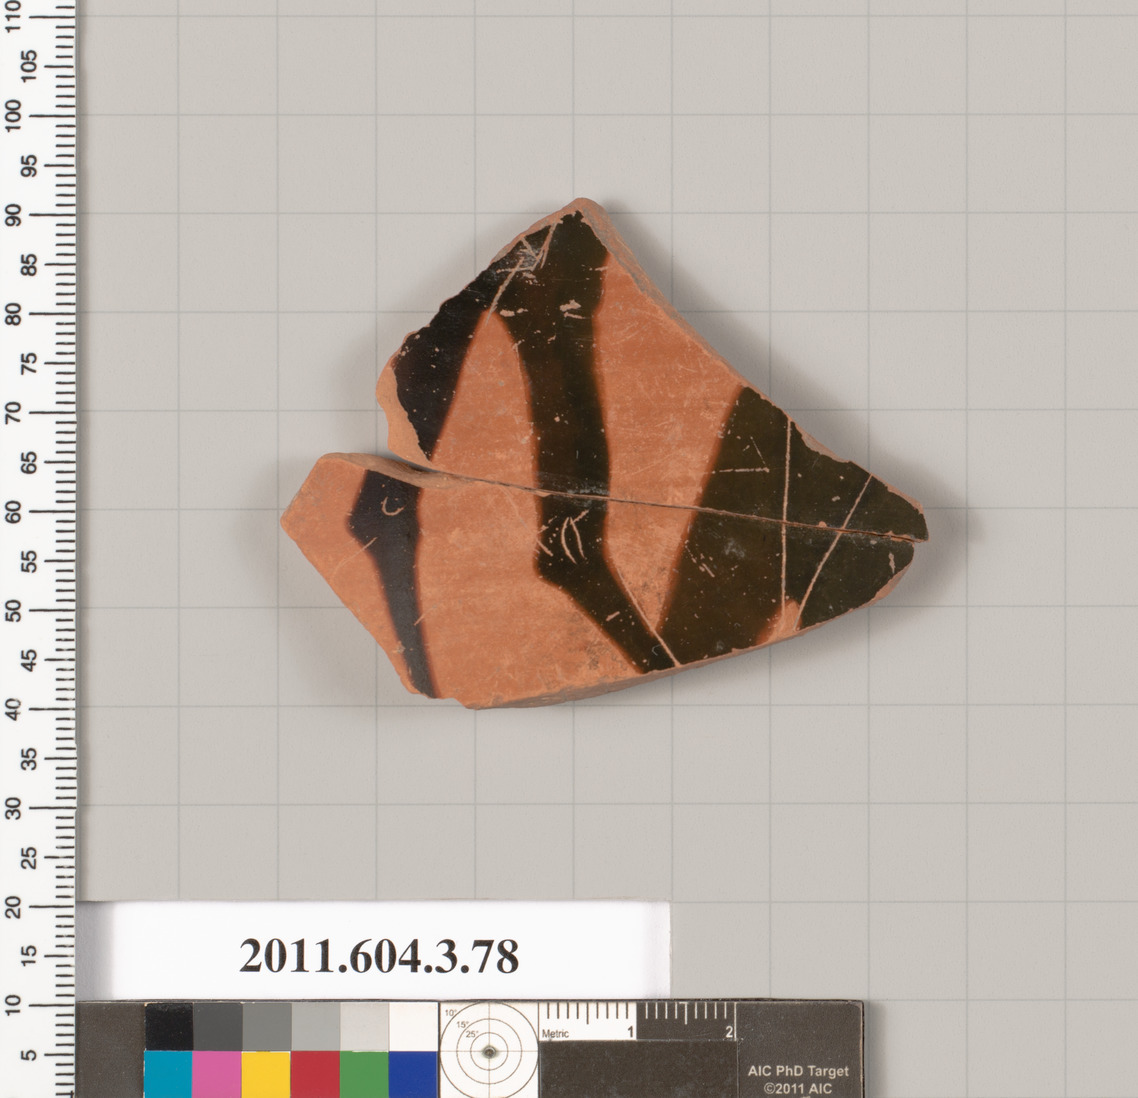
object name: amphora fragment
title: Terracotta fragment of an amphora (jar)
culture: greek, attic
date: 510-500 BCE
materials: terracotta